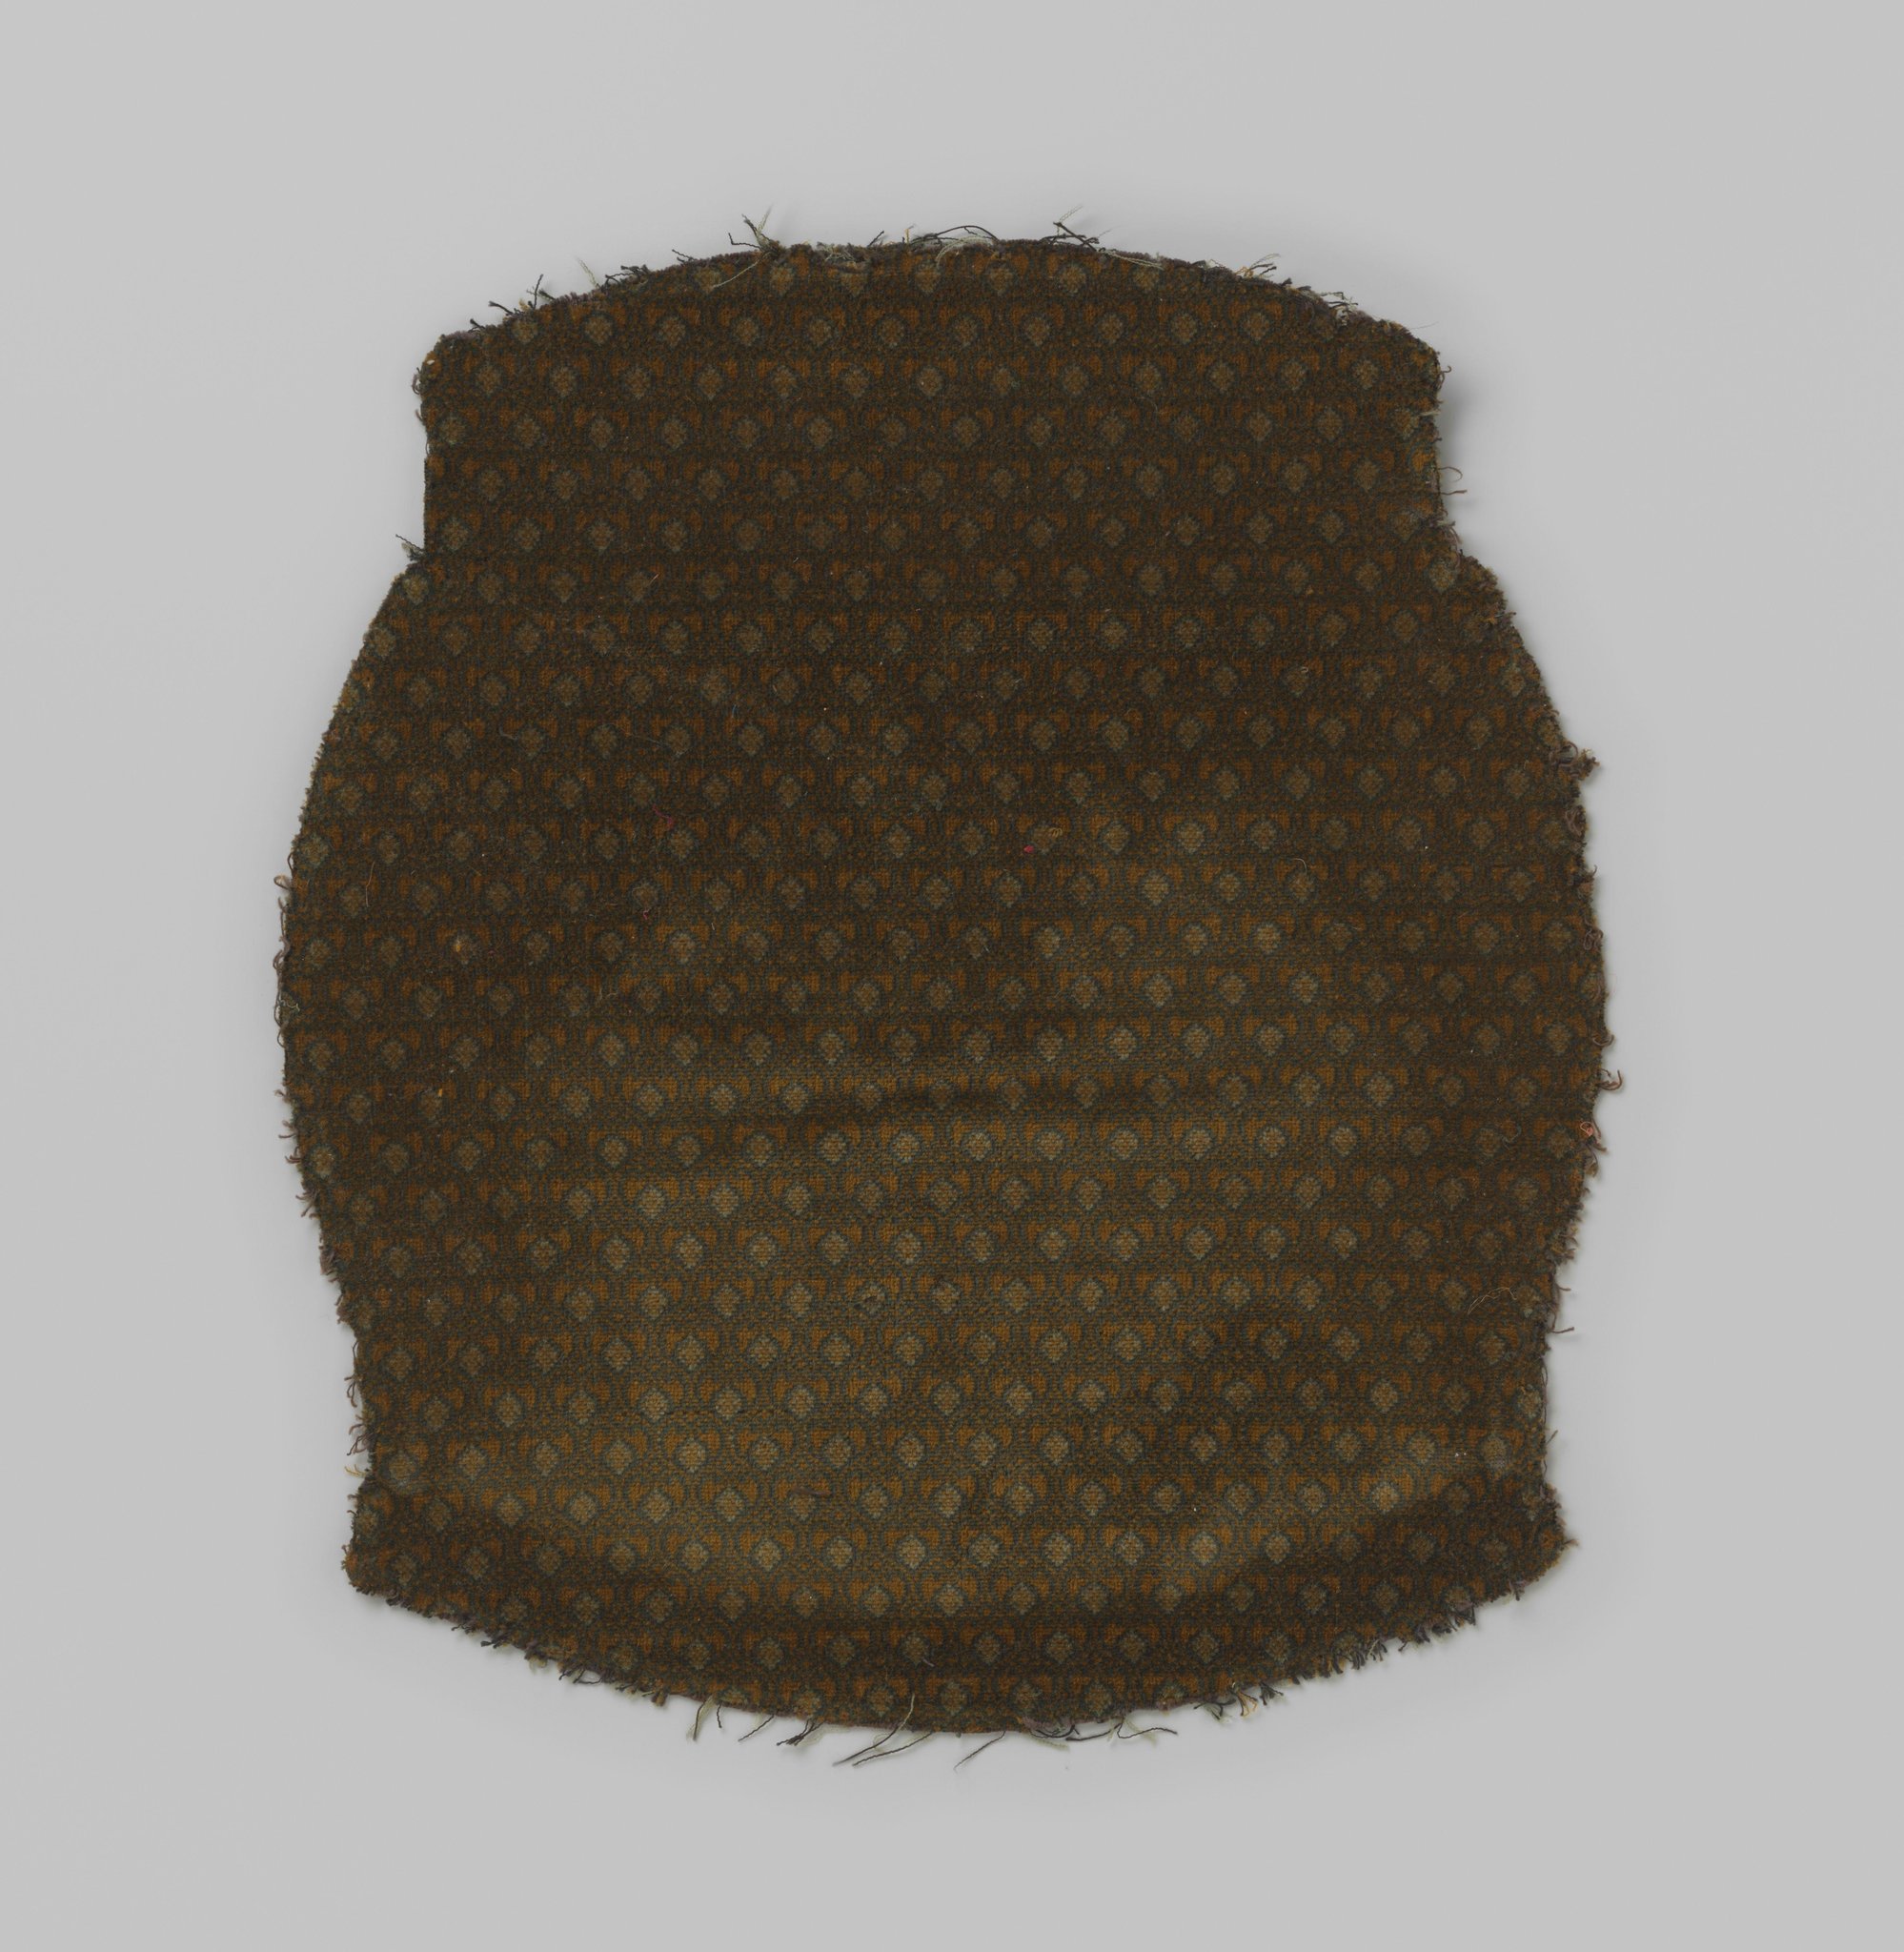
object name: upholstery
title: Fragmenten meubelbekleding van moquette met ogiefpatroon in lichtgroen, donkergroen en oranje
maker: theo nieuwenhuis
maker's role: designer, draughtsman, print maker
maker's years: 1866-1951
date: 1909-1920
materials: cotton, wool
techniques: jacquard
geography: netherlands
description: Fragment(en?) bedrukte trijp naar, mogelijk ontwerp Nieuwenhuis, met dessin van bloemen of vruchten. Opmerking: in kladinventaris wordt gesproken van fragmenten, maar er wordt geen aantal genoemd (Nieuwenh01).